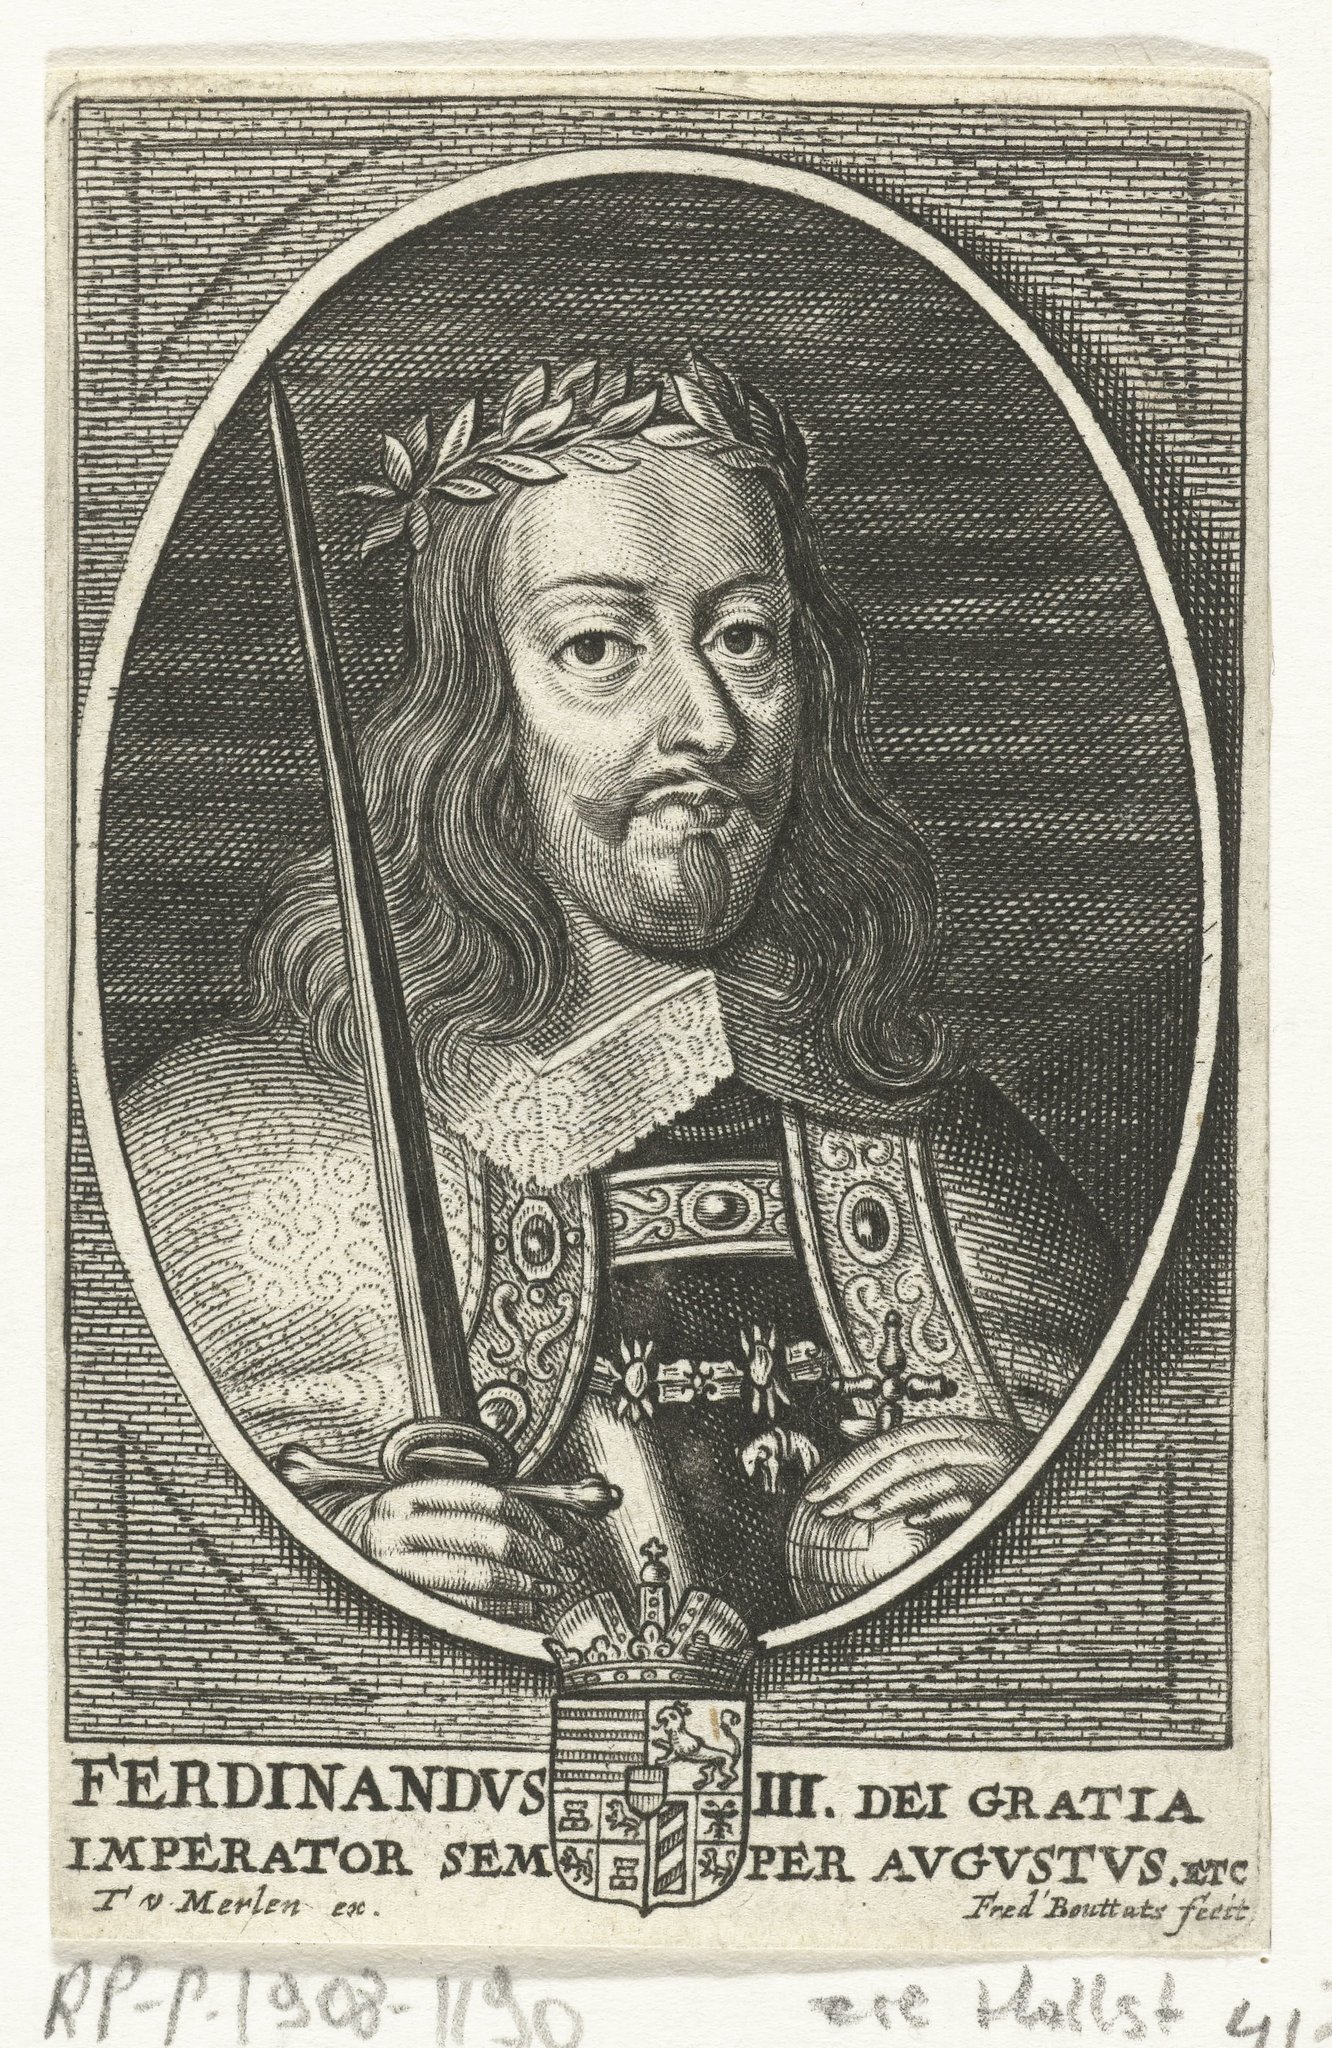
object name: print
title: Portretten van staatslieden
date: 1637-1676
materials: paper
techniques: engraving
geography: antwerp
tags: ferdinand iii (duits keizer)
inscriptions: collector's mark: Lugt 2228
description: Portret in een ovale lijst van Ferdinand III, aartshertog van Oostenrijk en keizer van het Heilig Roomse Rijk. Buste naar rechts. Ferdinand draagt de lauwerkrans op zijn hoofd. In zijn handen de rijksappel en het rijkszwaard. De prent heeft een Latijns onderschrift met de naam van de geportretteerde.